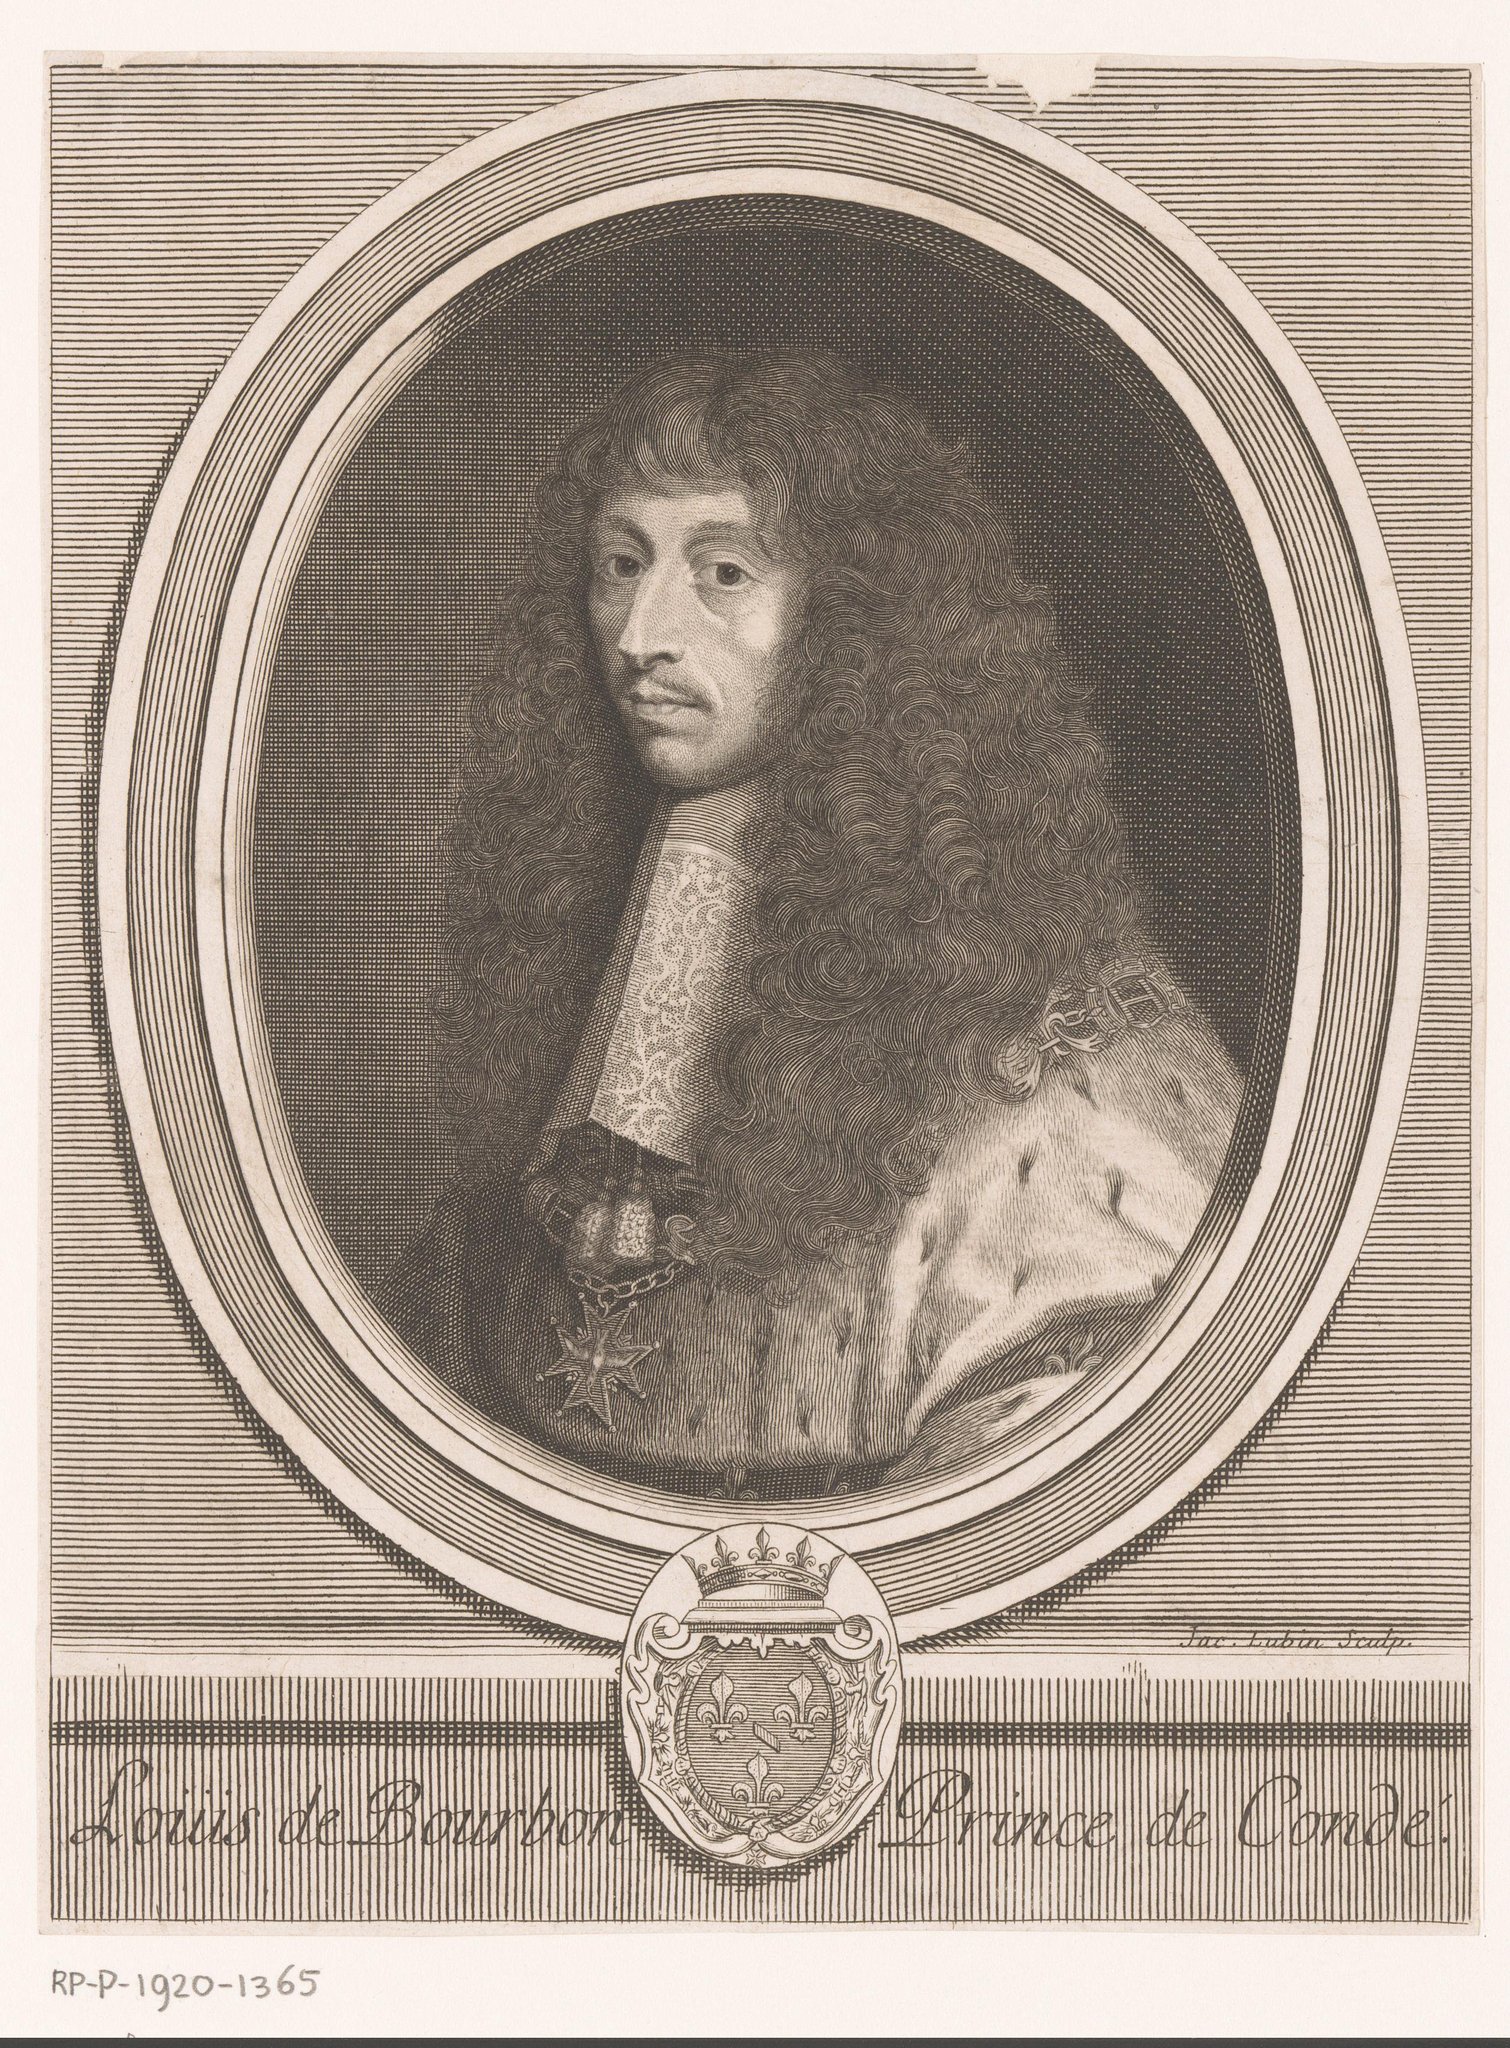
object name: book illustration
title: Portret van Louis II de Bourbon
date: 1696-1700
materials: paper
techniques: engraving, etching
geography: paris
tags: prince, historical persons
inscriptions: collector's mark: Lugt 2228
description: Prent uit: Perrault, Charles. Les hommes illustres qui ont paru en France pendant ce siècle. Parijs: Antoine Dezallier, 1696-1700.